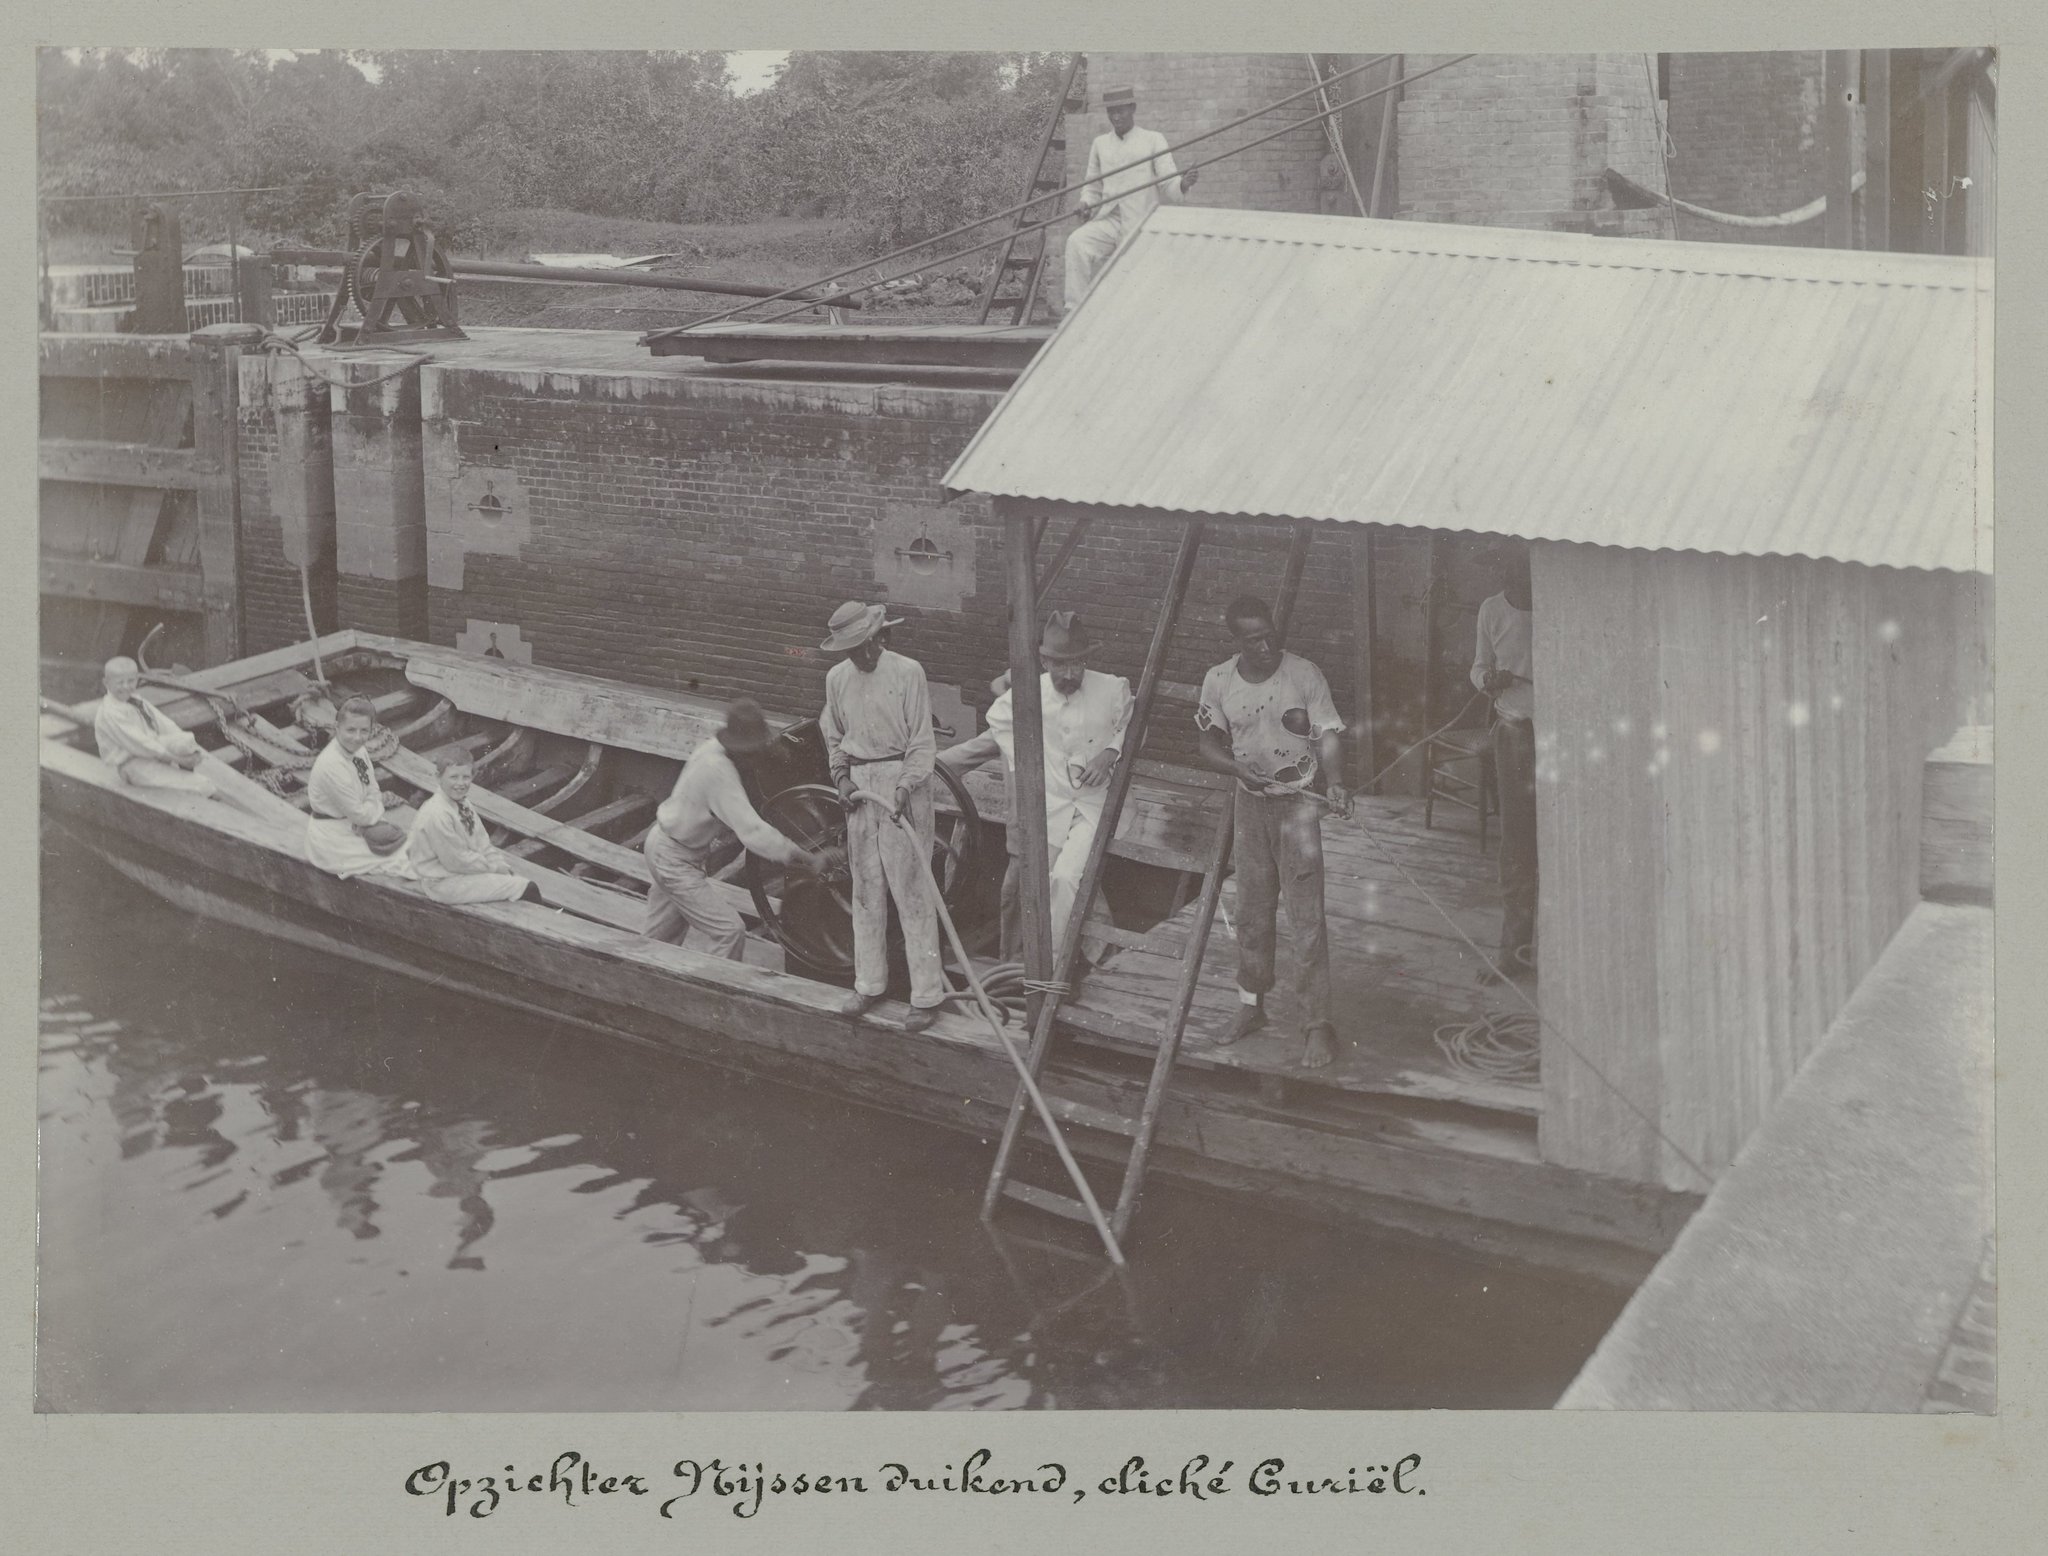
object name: photograph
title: Opzichter Nijssen duikend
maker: augusta curiel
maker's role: fotograaf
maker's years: 1873-1937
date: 1900-1913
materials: photographic support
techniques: collodion silver print, gelatin silver print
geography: suriname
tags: suriname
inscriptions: inscription: ‘Opzichter Nijssen duikend, cliché Curiël.’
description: Een werkboot in het water tijdens werkzaamheden bij de Havelaarsluis bij Beekhuizen. In de boot zitten drie Europese kinderen die toezien hoe de opzichter Nijssen onderwater werkt. Onderdeel van het fotoalbum Souvenir de Voyage (deel 3), over het leven van de familie Dooyer in en rond de plantage Ma Retraite in Suriname in de jaren 1906-1913.